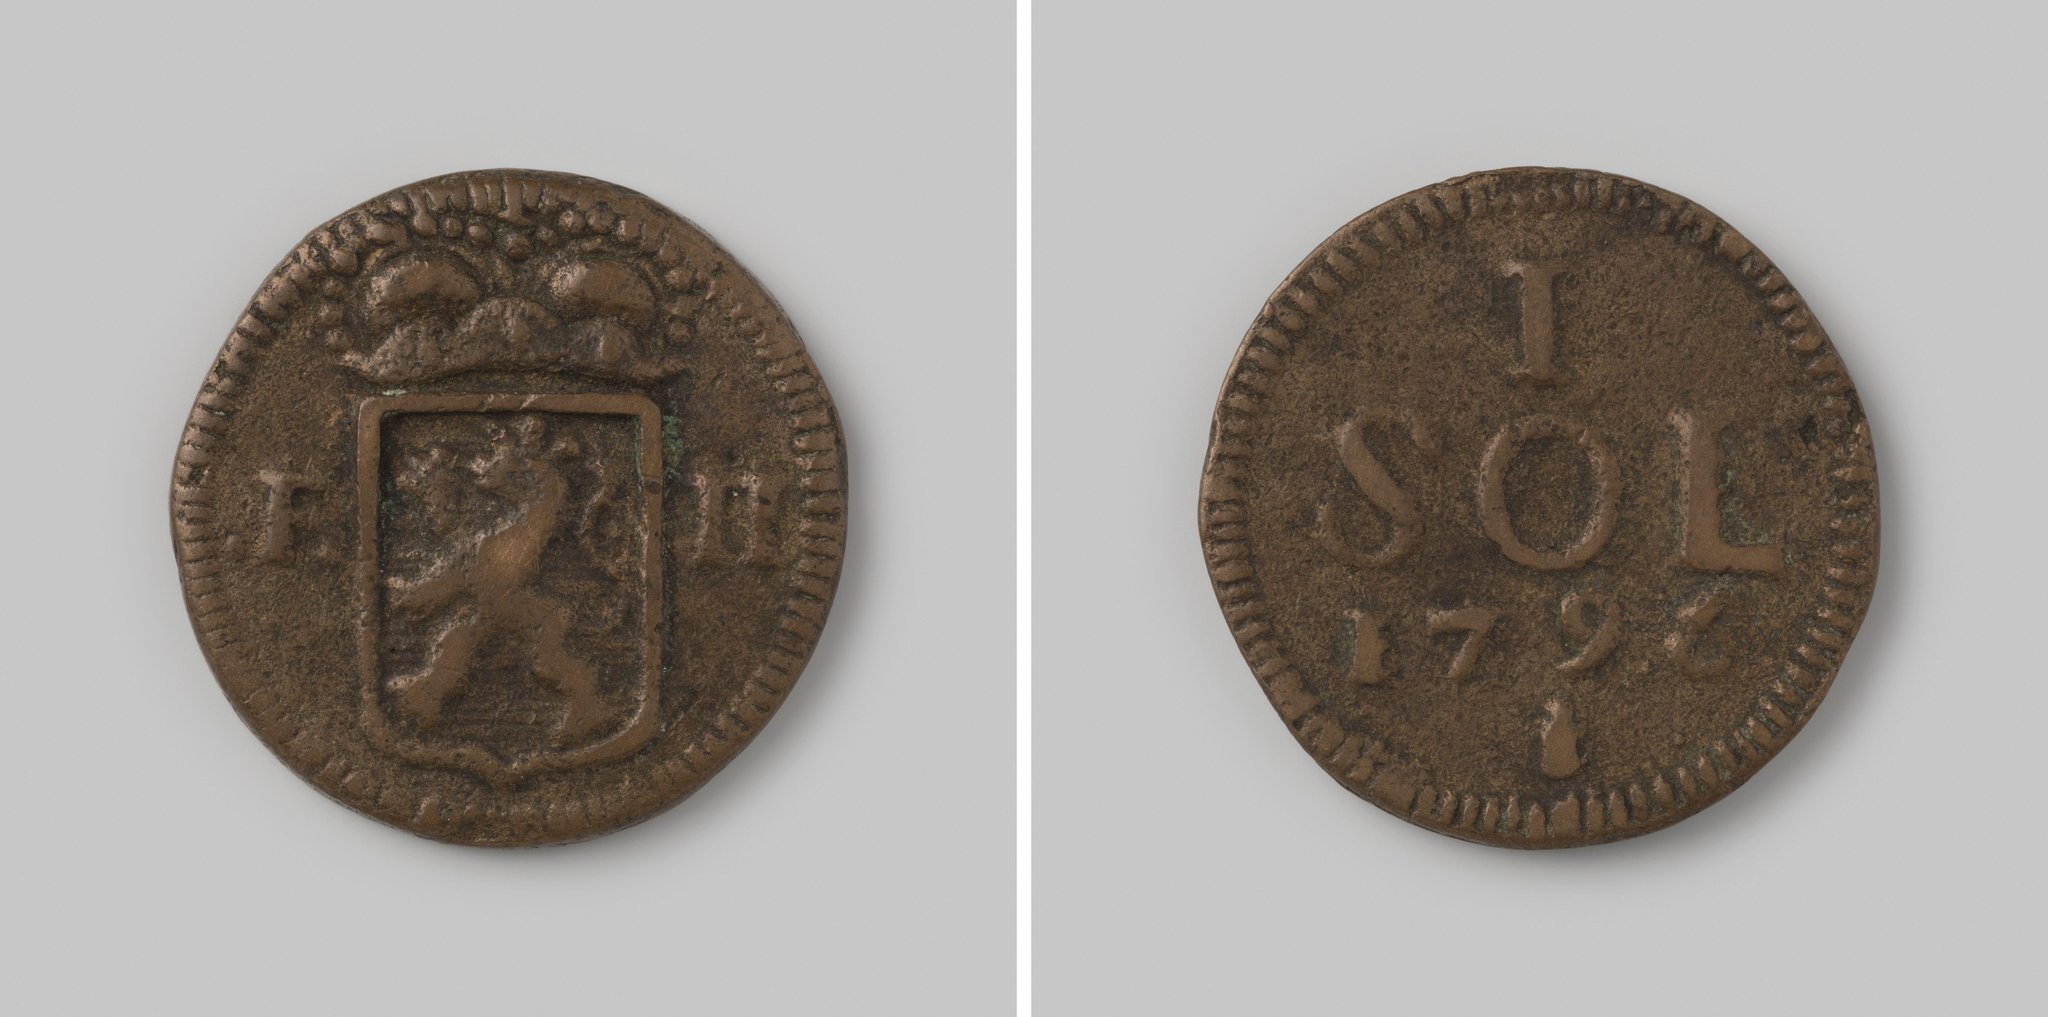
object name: sol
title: Sol, noodmunt uit Luxemburg van Frans II, 1796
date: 1796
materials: bronze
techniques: casting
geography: luxembourg city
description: Bronzen noodmunt. Voorzijde: tussen aanduiding F II gekroond wapenschild. Keerzijde: in twee regels waarde-aanduiding, waaronder jaartal. Gladde rand.